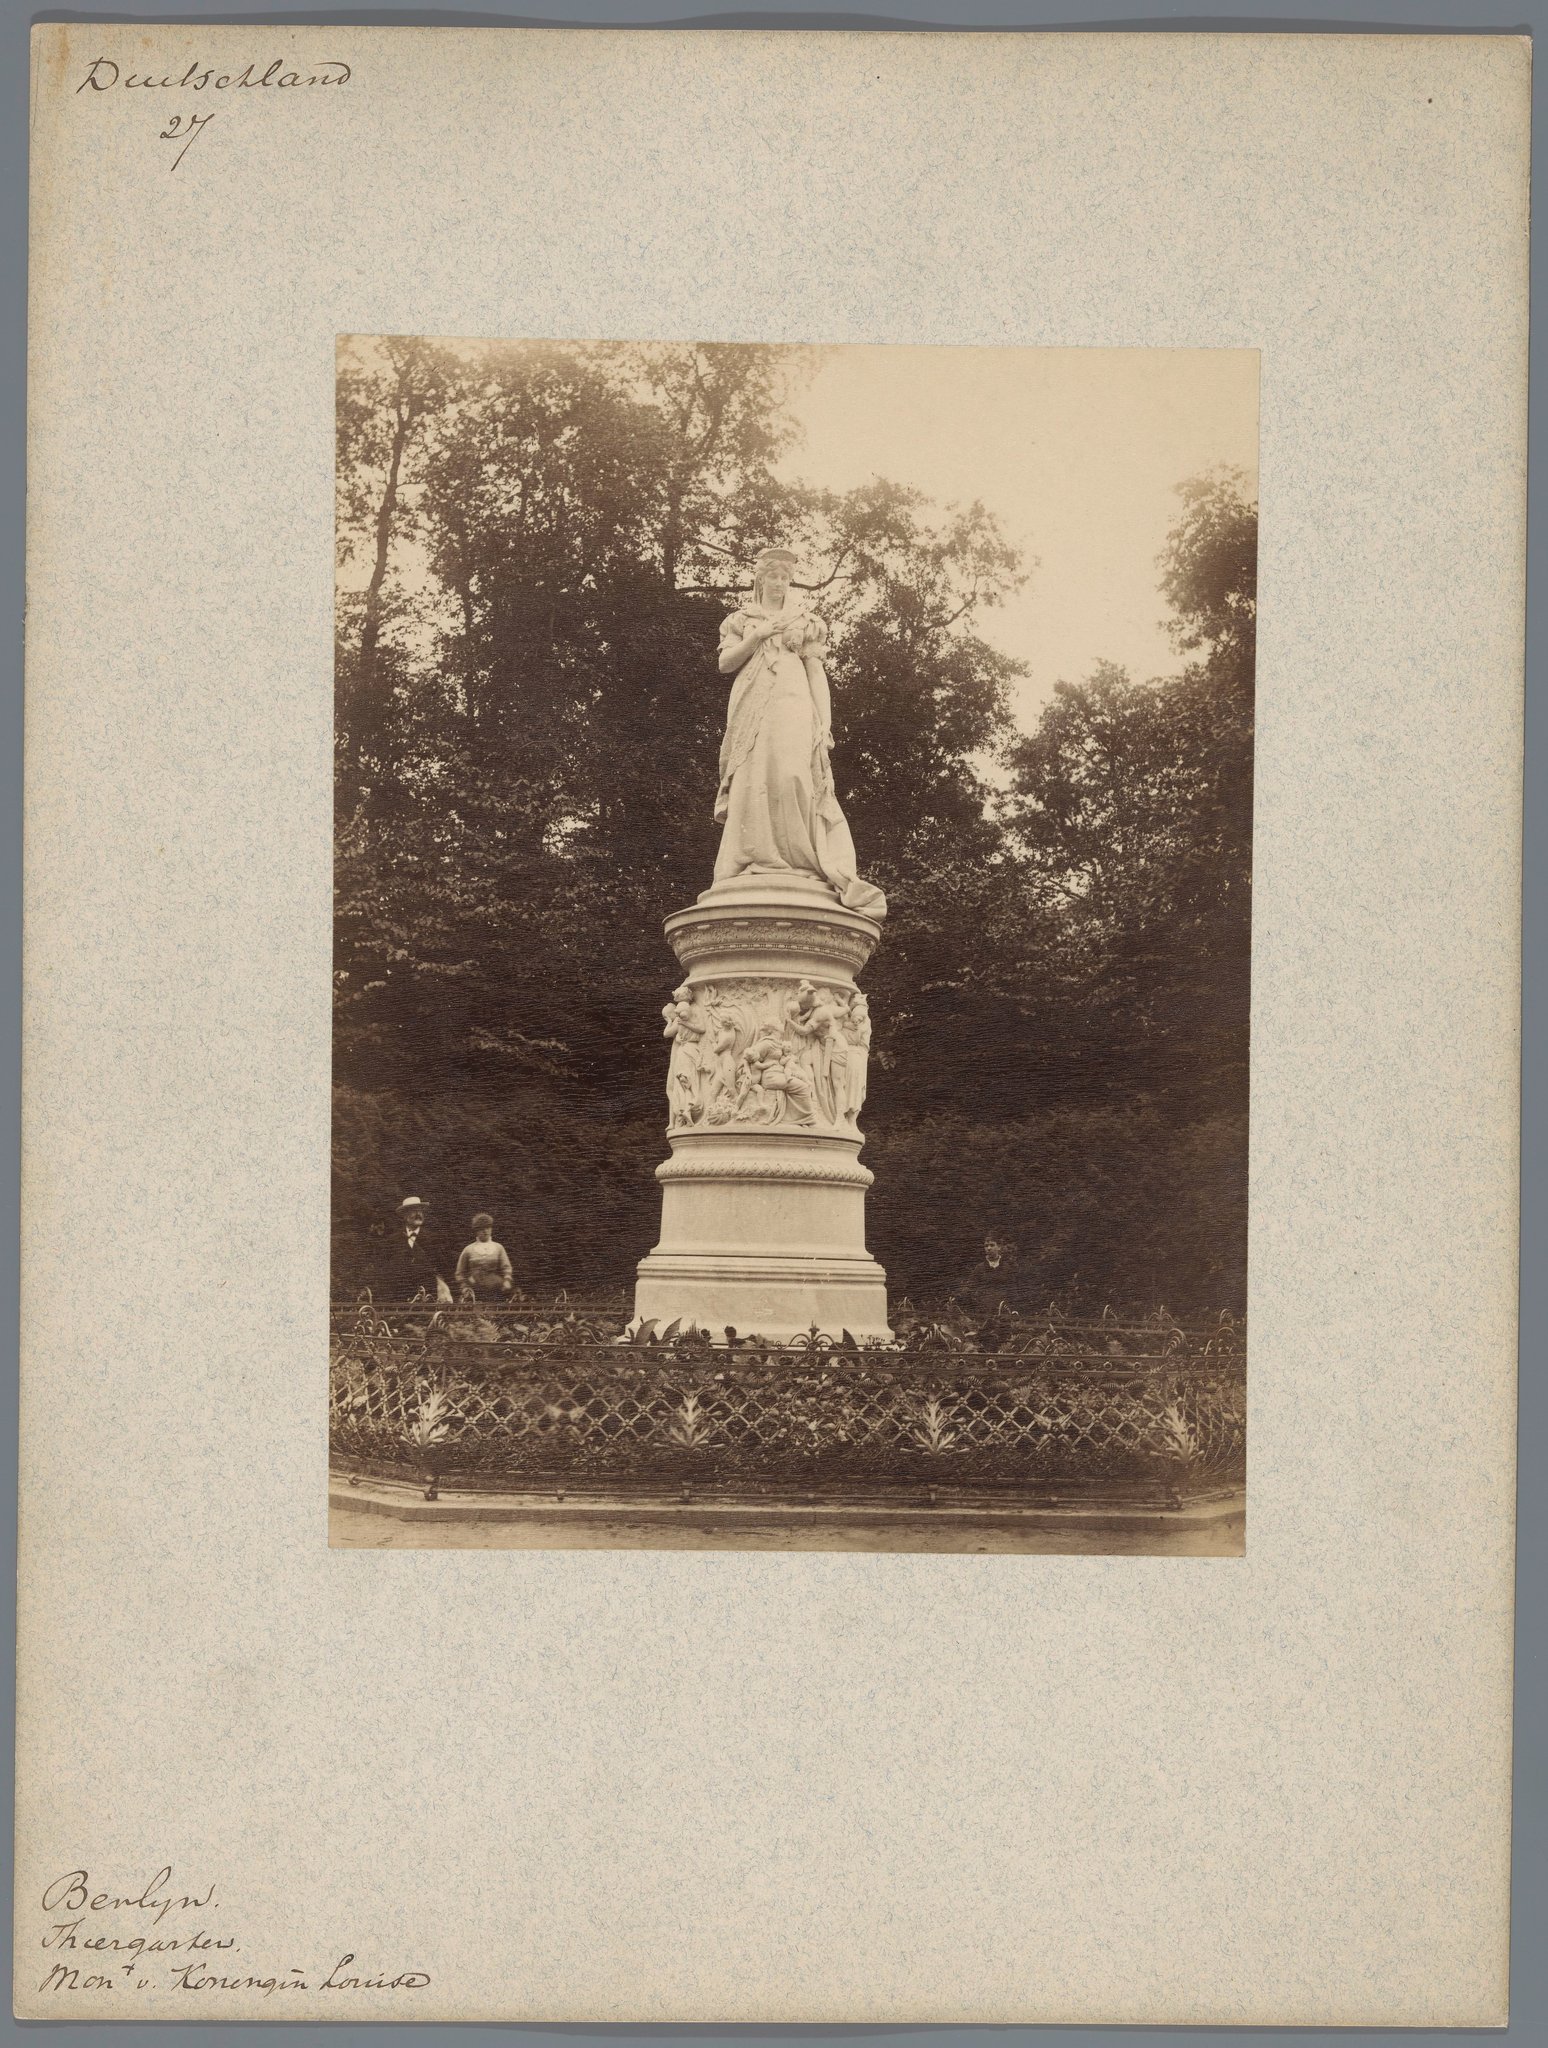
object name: photograph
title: Monument van Koningin Louise te Berlijn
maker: Anonymous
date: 1850-1900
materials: cardboard, photographic support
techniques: albumen print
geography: berlin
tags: monument, statue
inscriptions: collector's mark: ‘Rijks normaalschool voor teekenonderwijzers Amsterdam’, inscription: ‘Berlijn/ Tiergarten./ Monv. Koningin Louise’, inscription: ‘Duitschland/ 27’